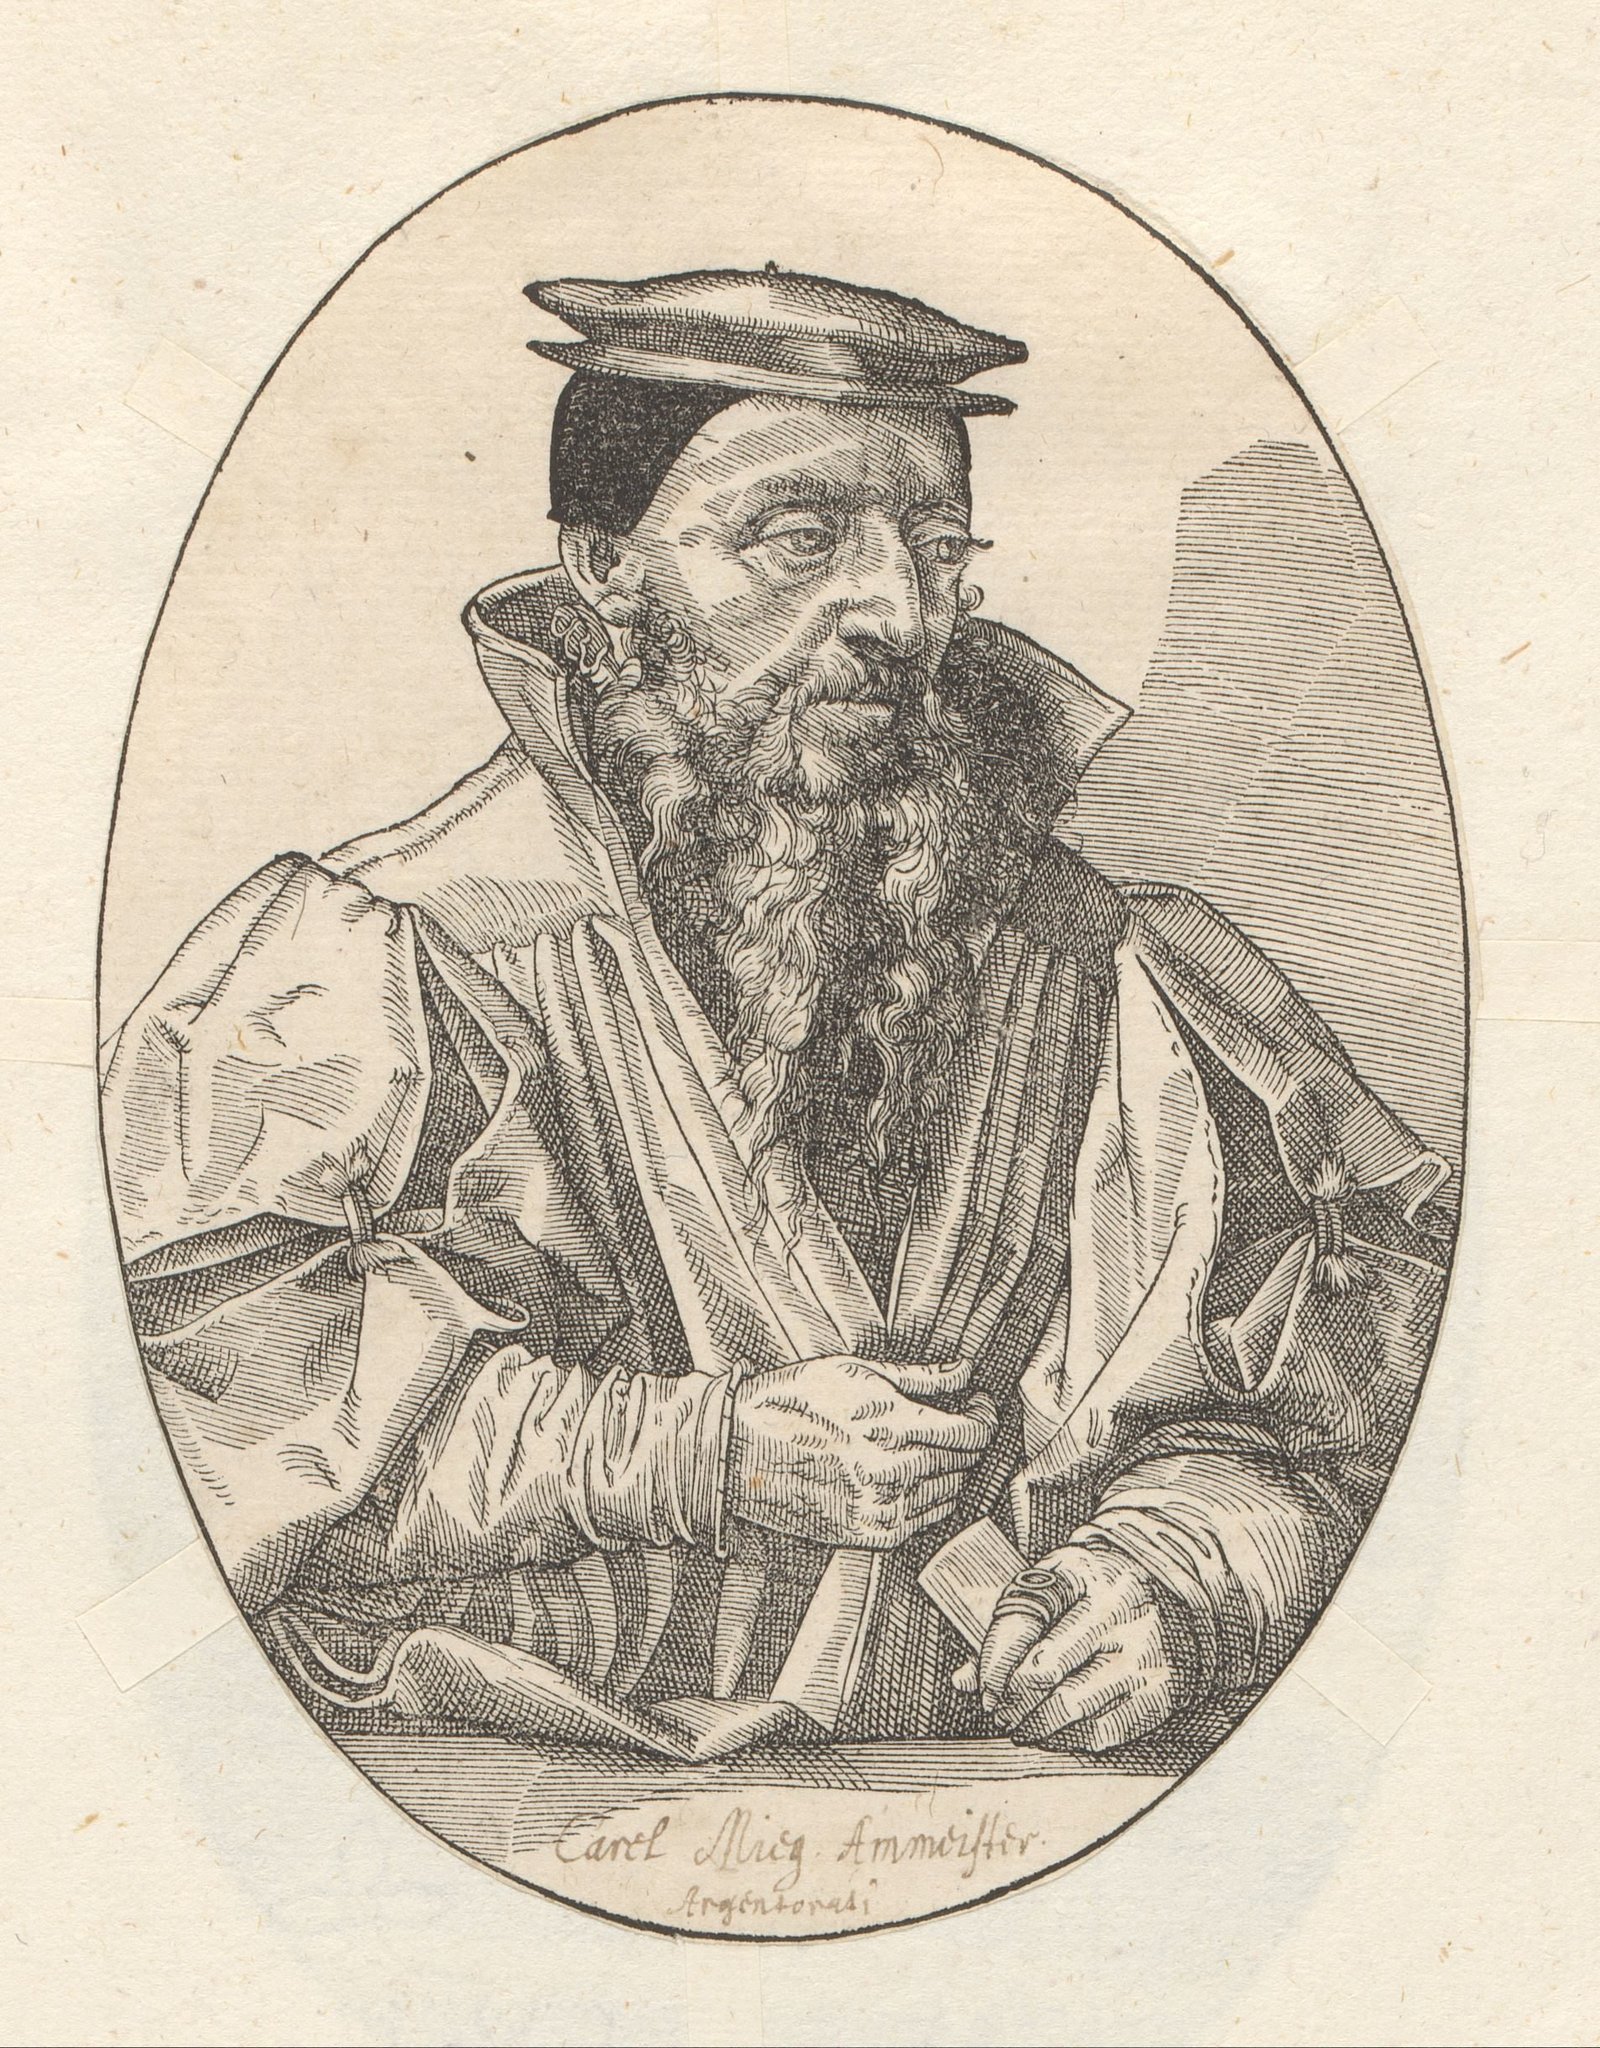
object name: album leaf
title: Portret van Karl von Mieg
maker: Anonymous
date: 1549-1584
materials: paper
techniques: woodcut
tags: further education (+ portrait of teacher, professor), historical persons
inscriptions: annotation: ‘Carel Mieg Ammeister Argentorati’